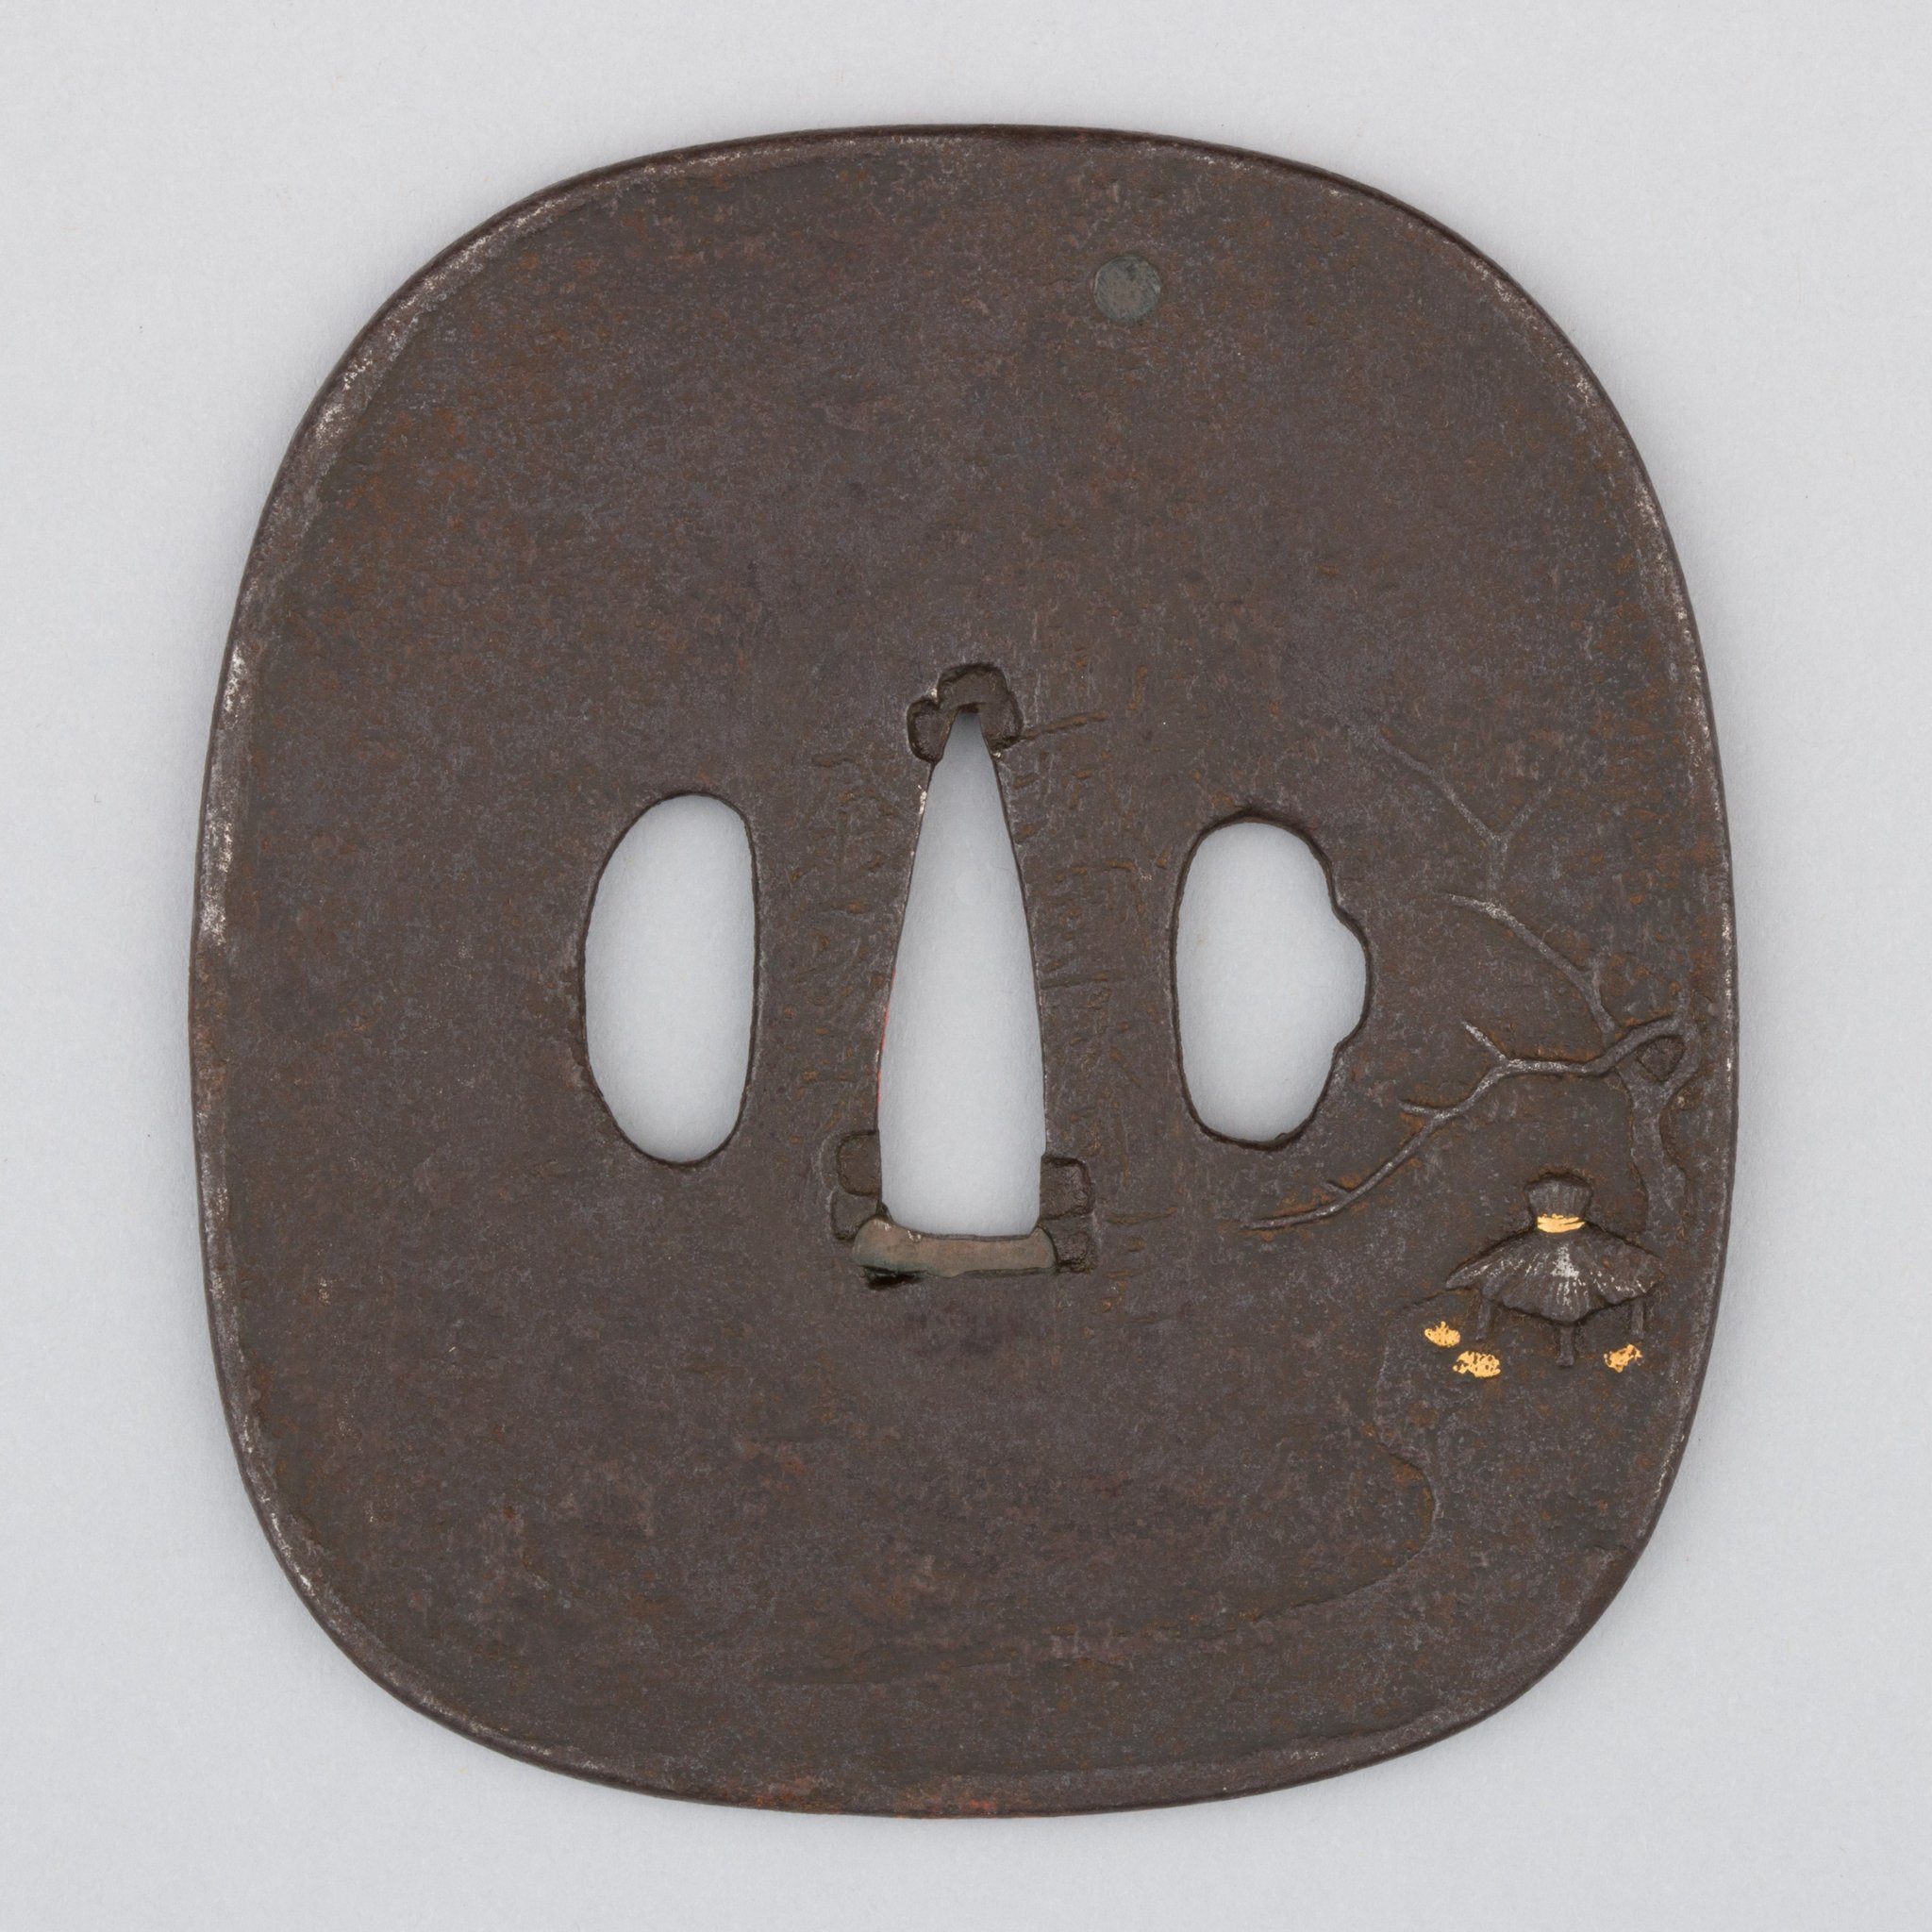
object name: sword guard tsuba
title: Sword Guard (Tsuba)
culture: japanese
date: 1615-1868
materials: copper, iron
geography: japan